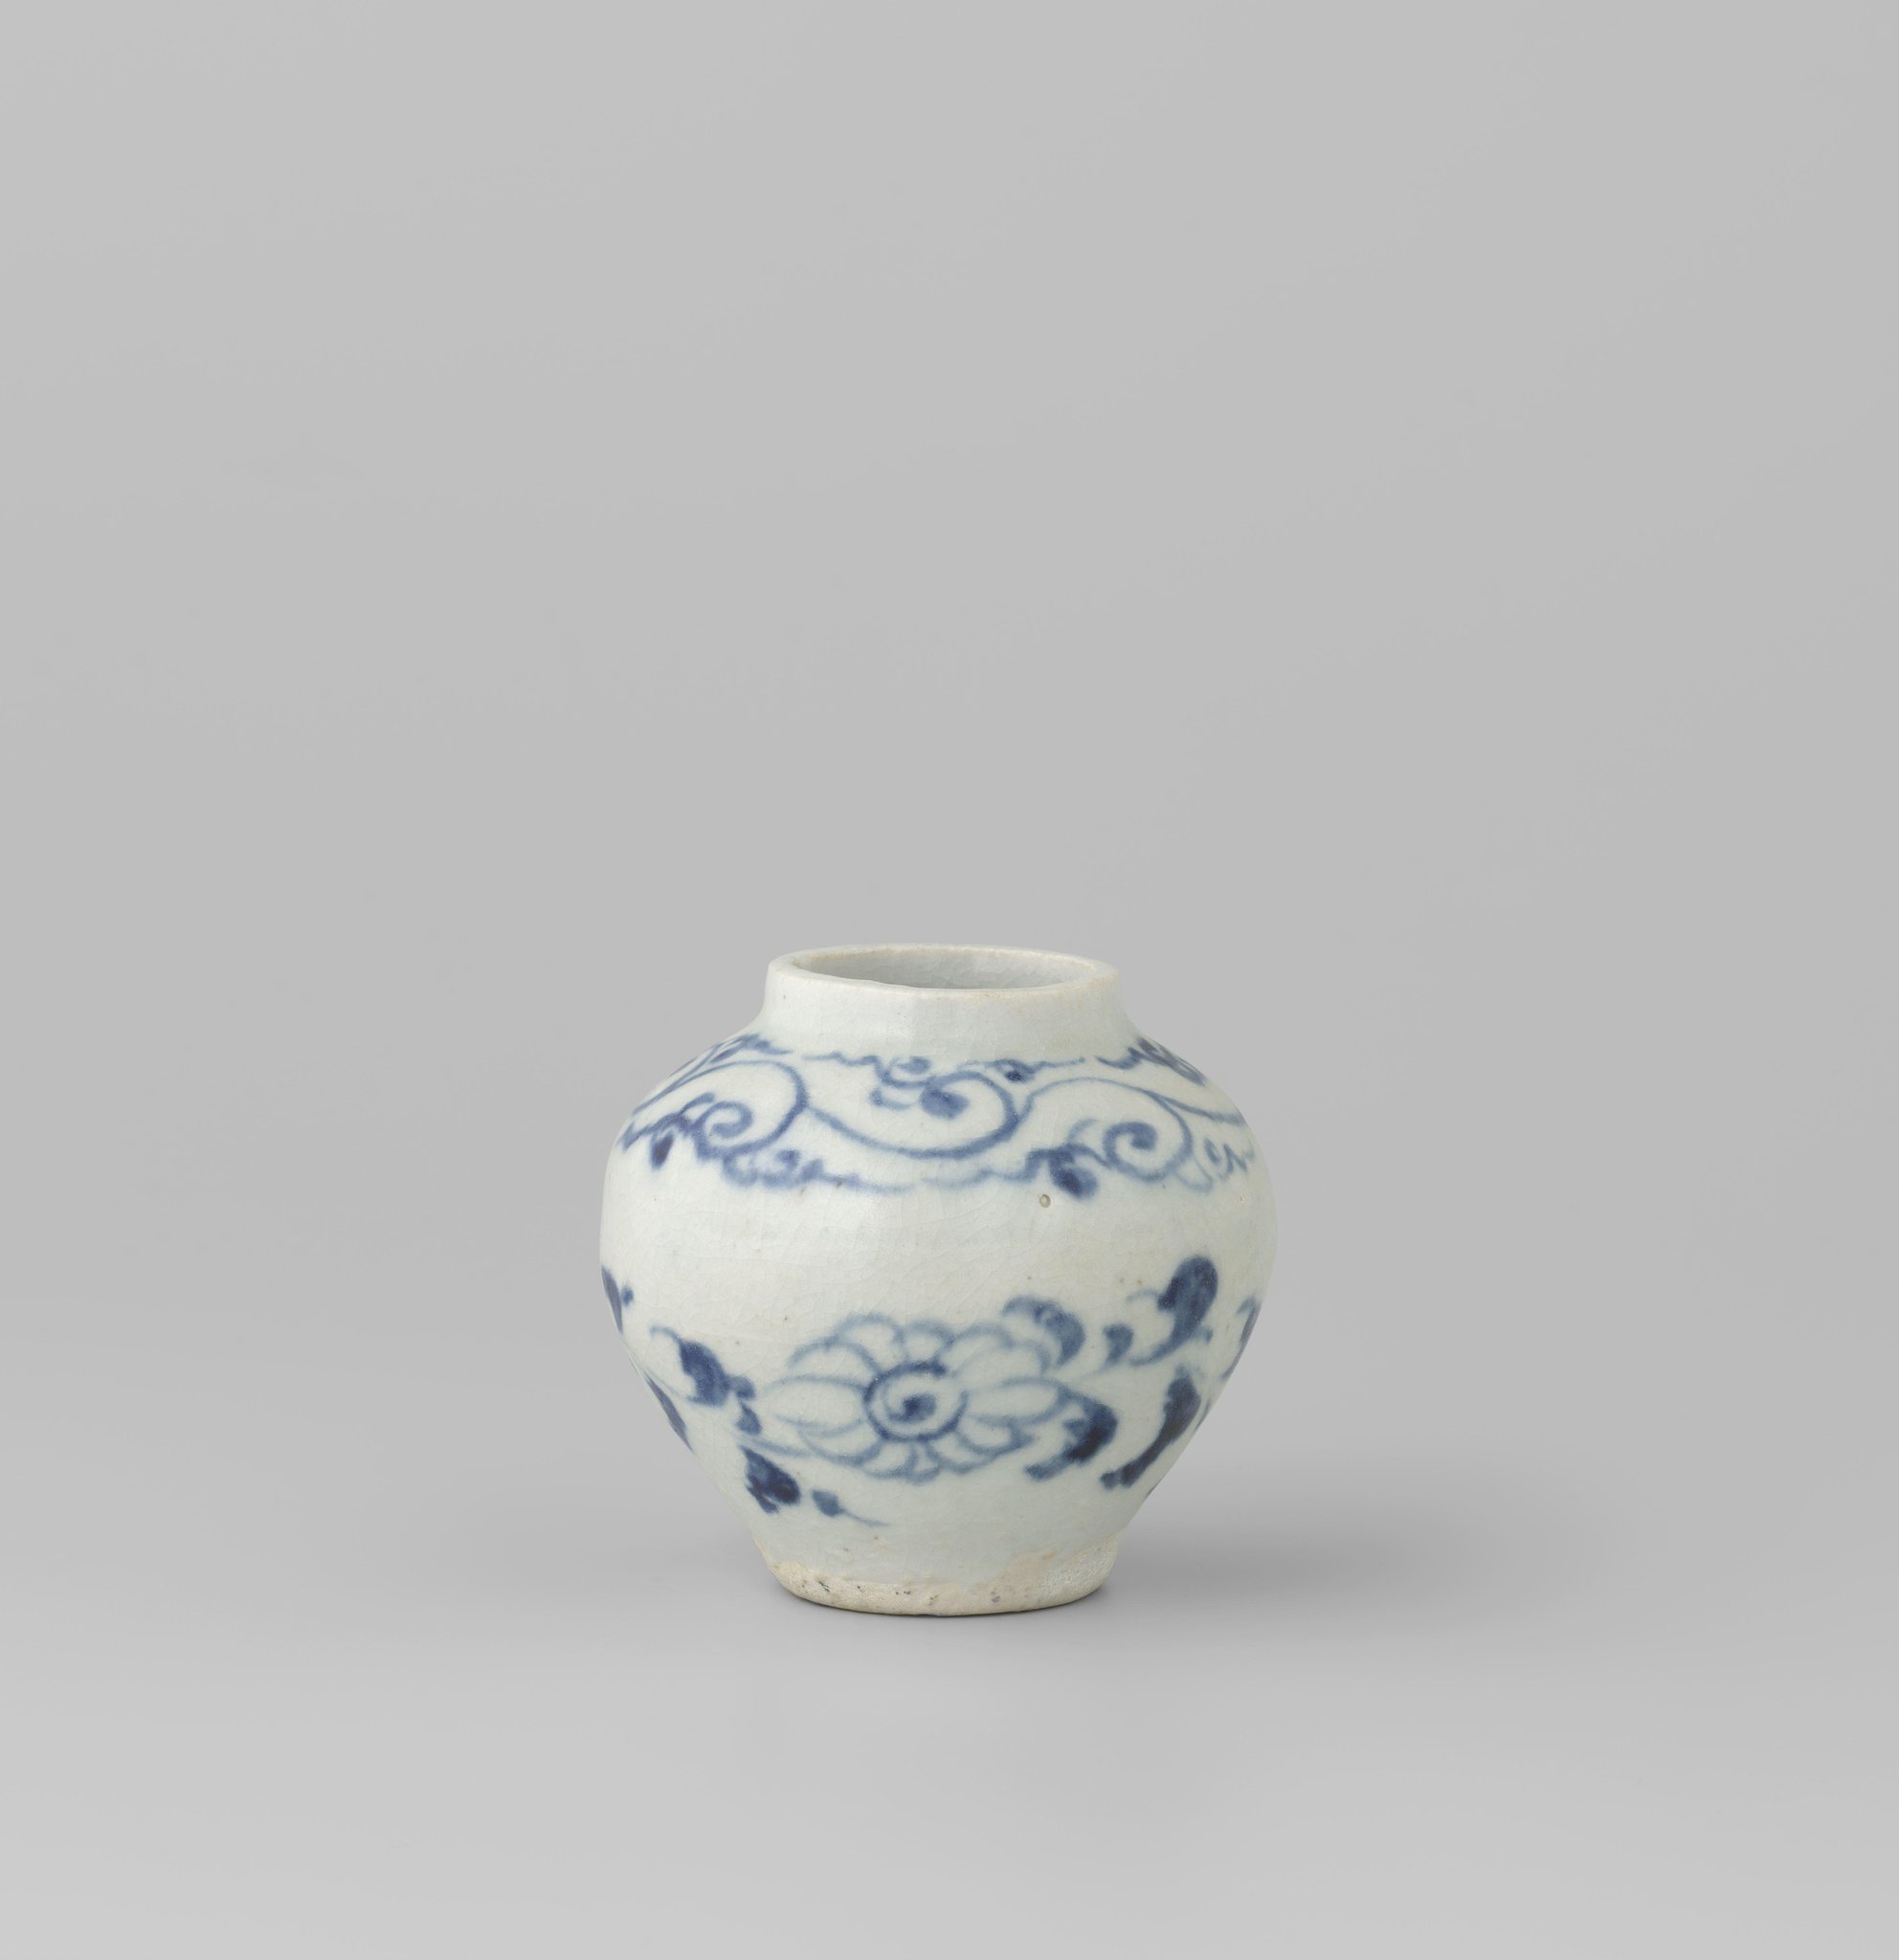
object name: miniature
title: Jarlet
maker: Anonymous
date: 1279-1368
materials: paint, porcelain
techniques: firing, forming, vitrification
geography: china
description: Het lichaam van de balustervormige pot is versierd met een horizontale bloesemtak, de hals met een doorlopend wolkenpatroon.